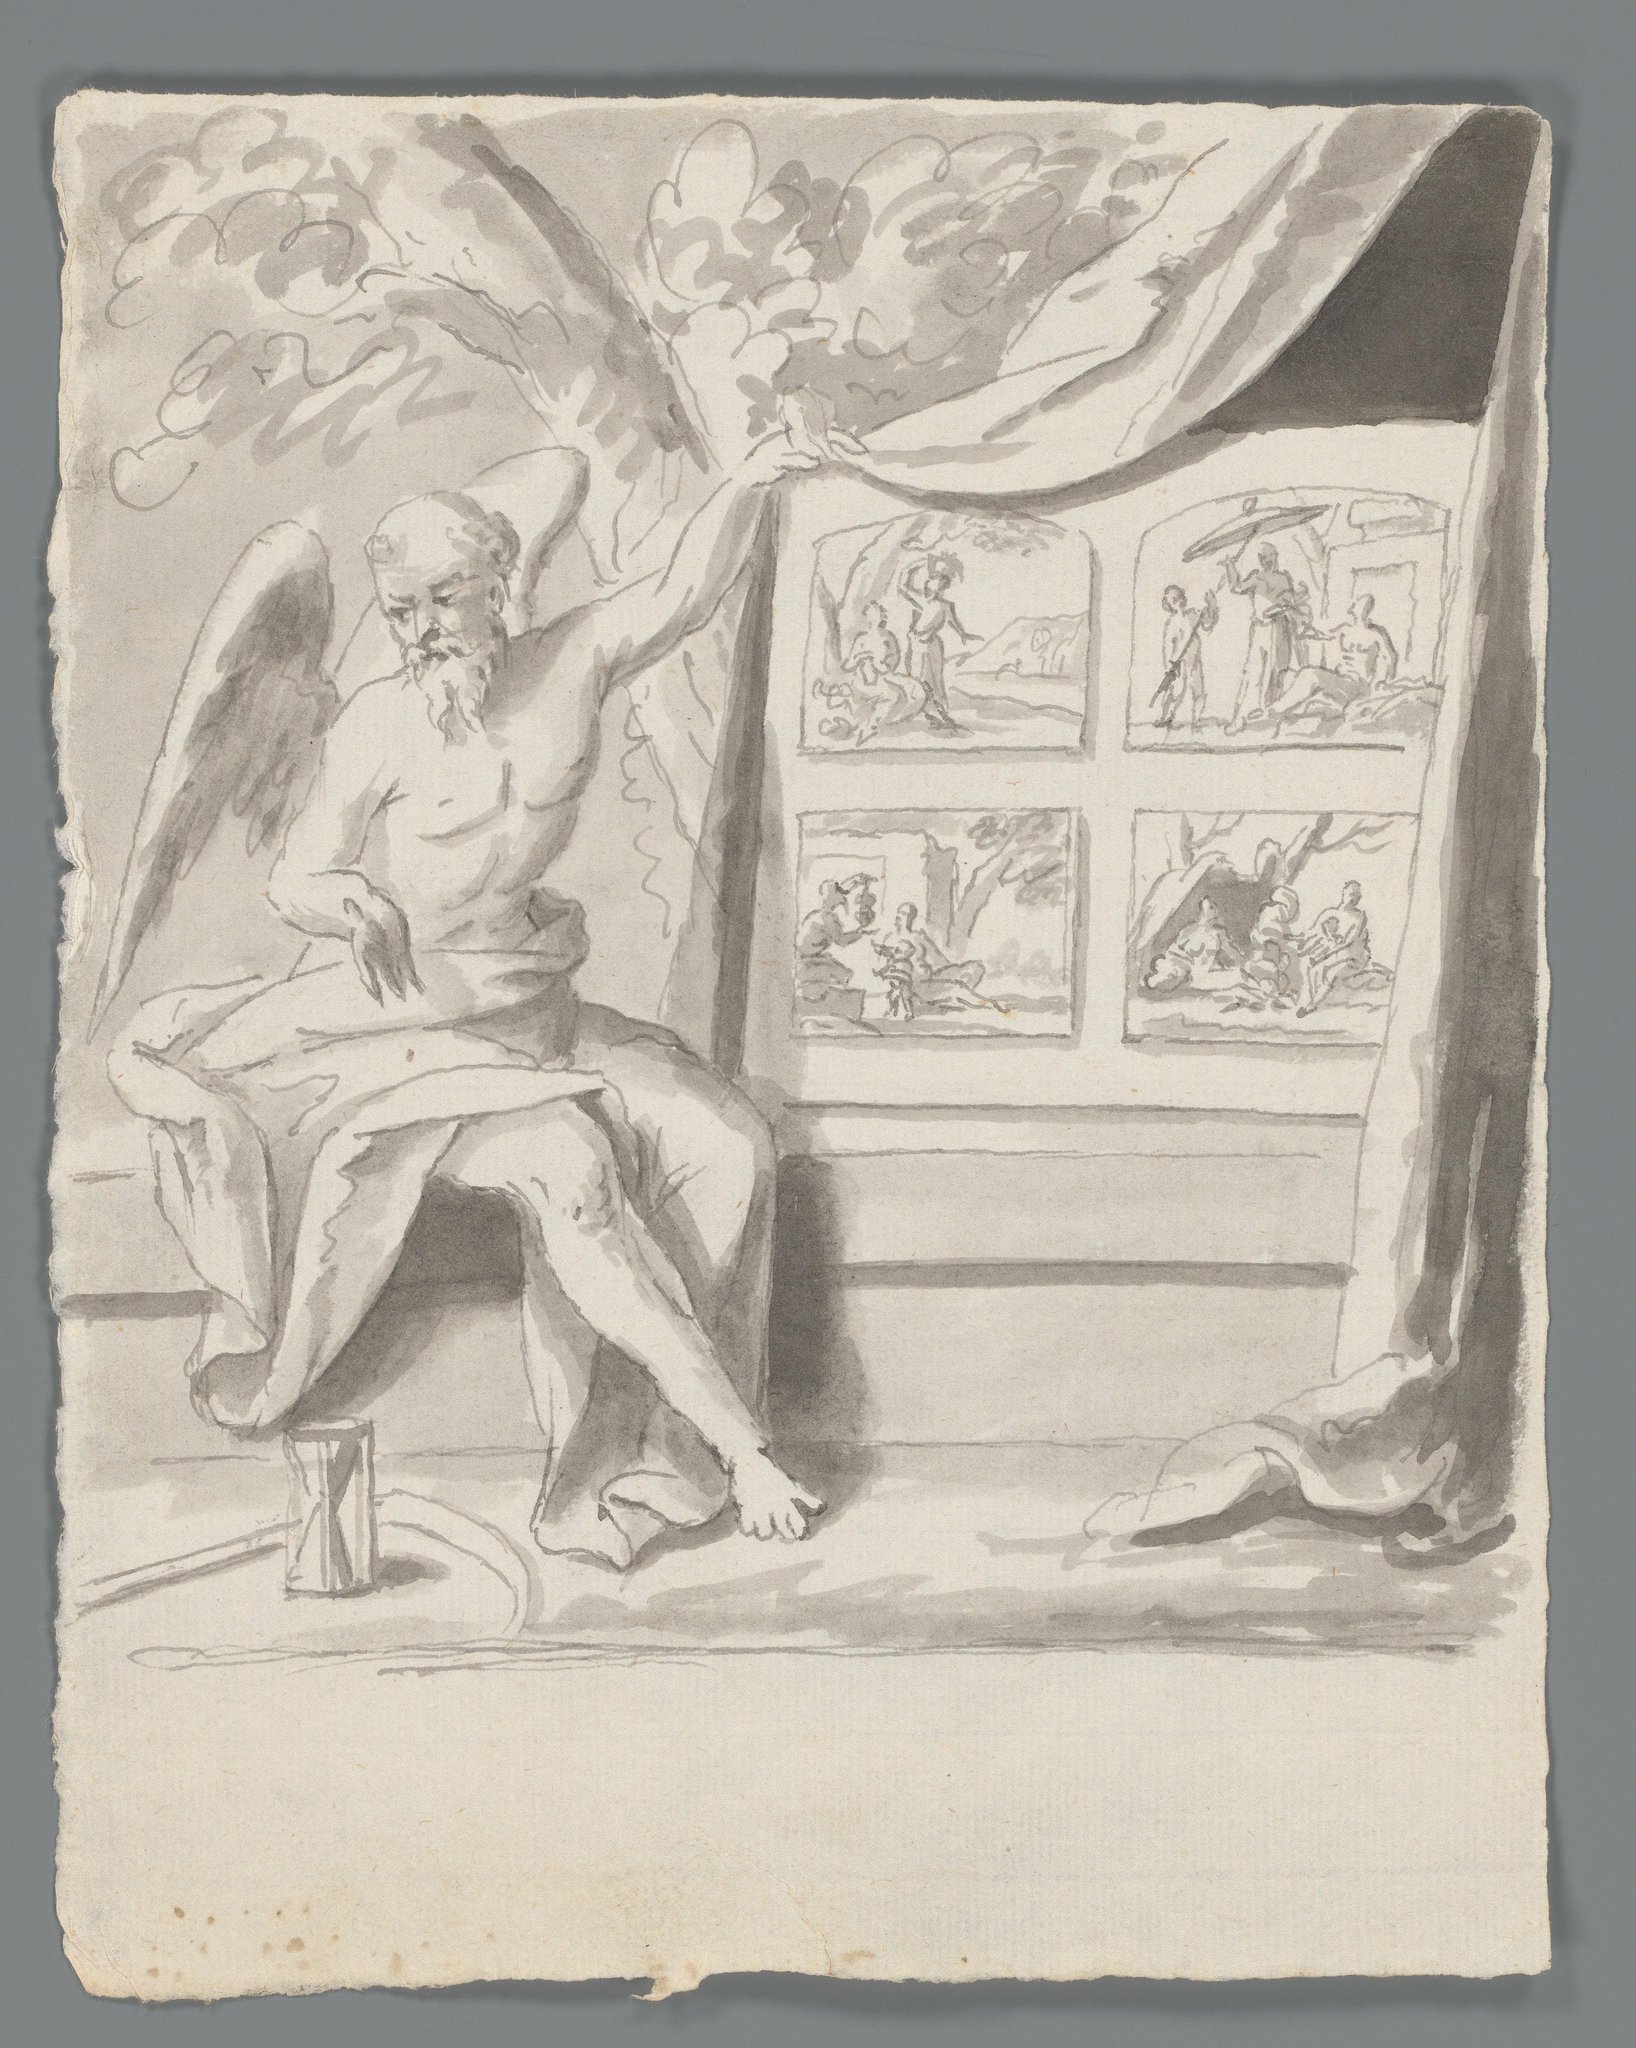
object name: drawing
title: Tijd laat vier schilderijen zien achter een gordijn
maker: matthijs balen (1684-1766)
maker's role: draughtsman, painter, print maker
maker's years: 1684-1766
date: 1694-1766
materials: paper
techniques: brush, pen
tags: picture, painting, father time, man with wings and scythe